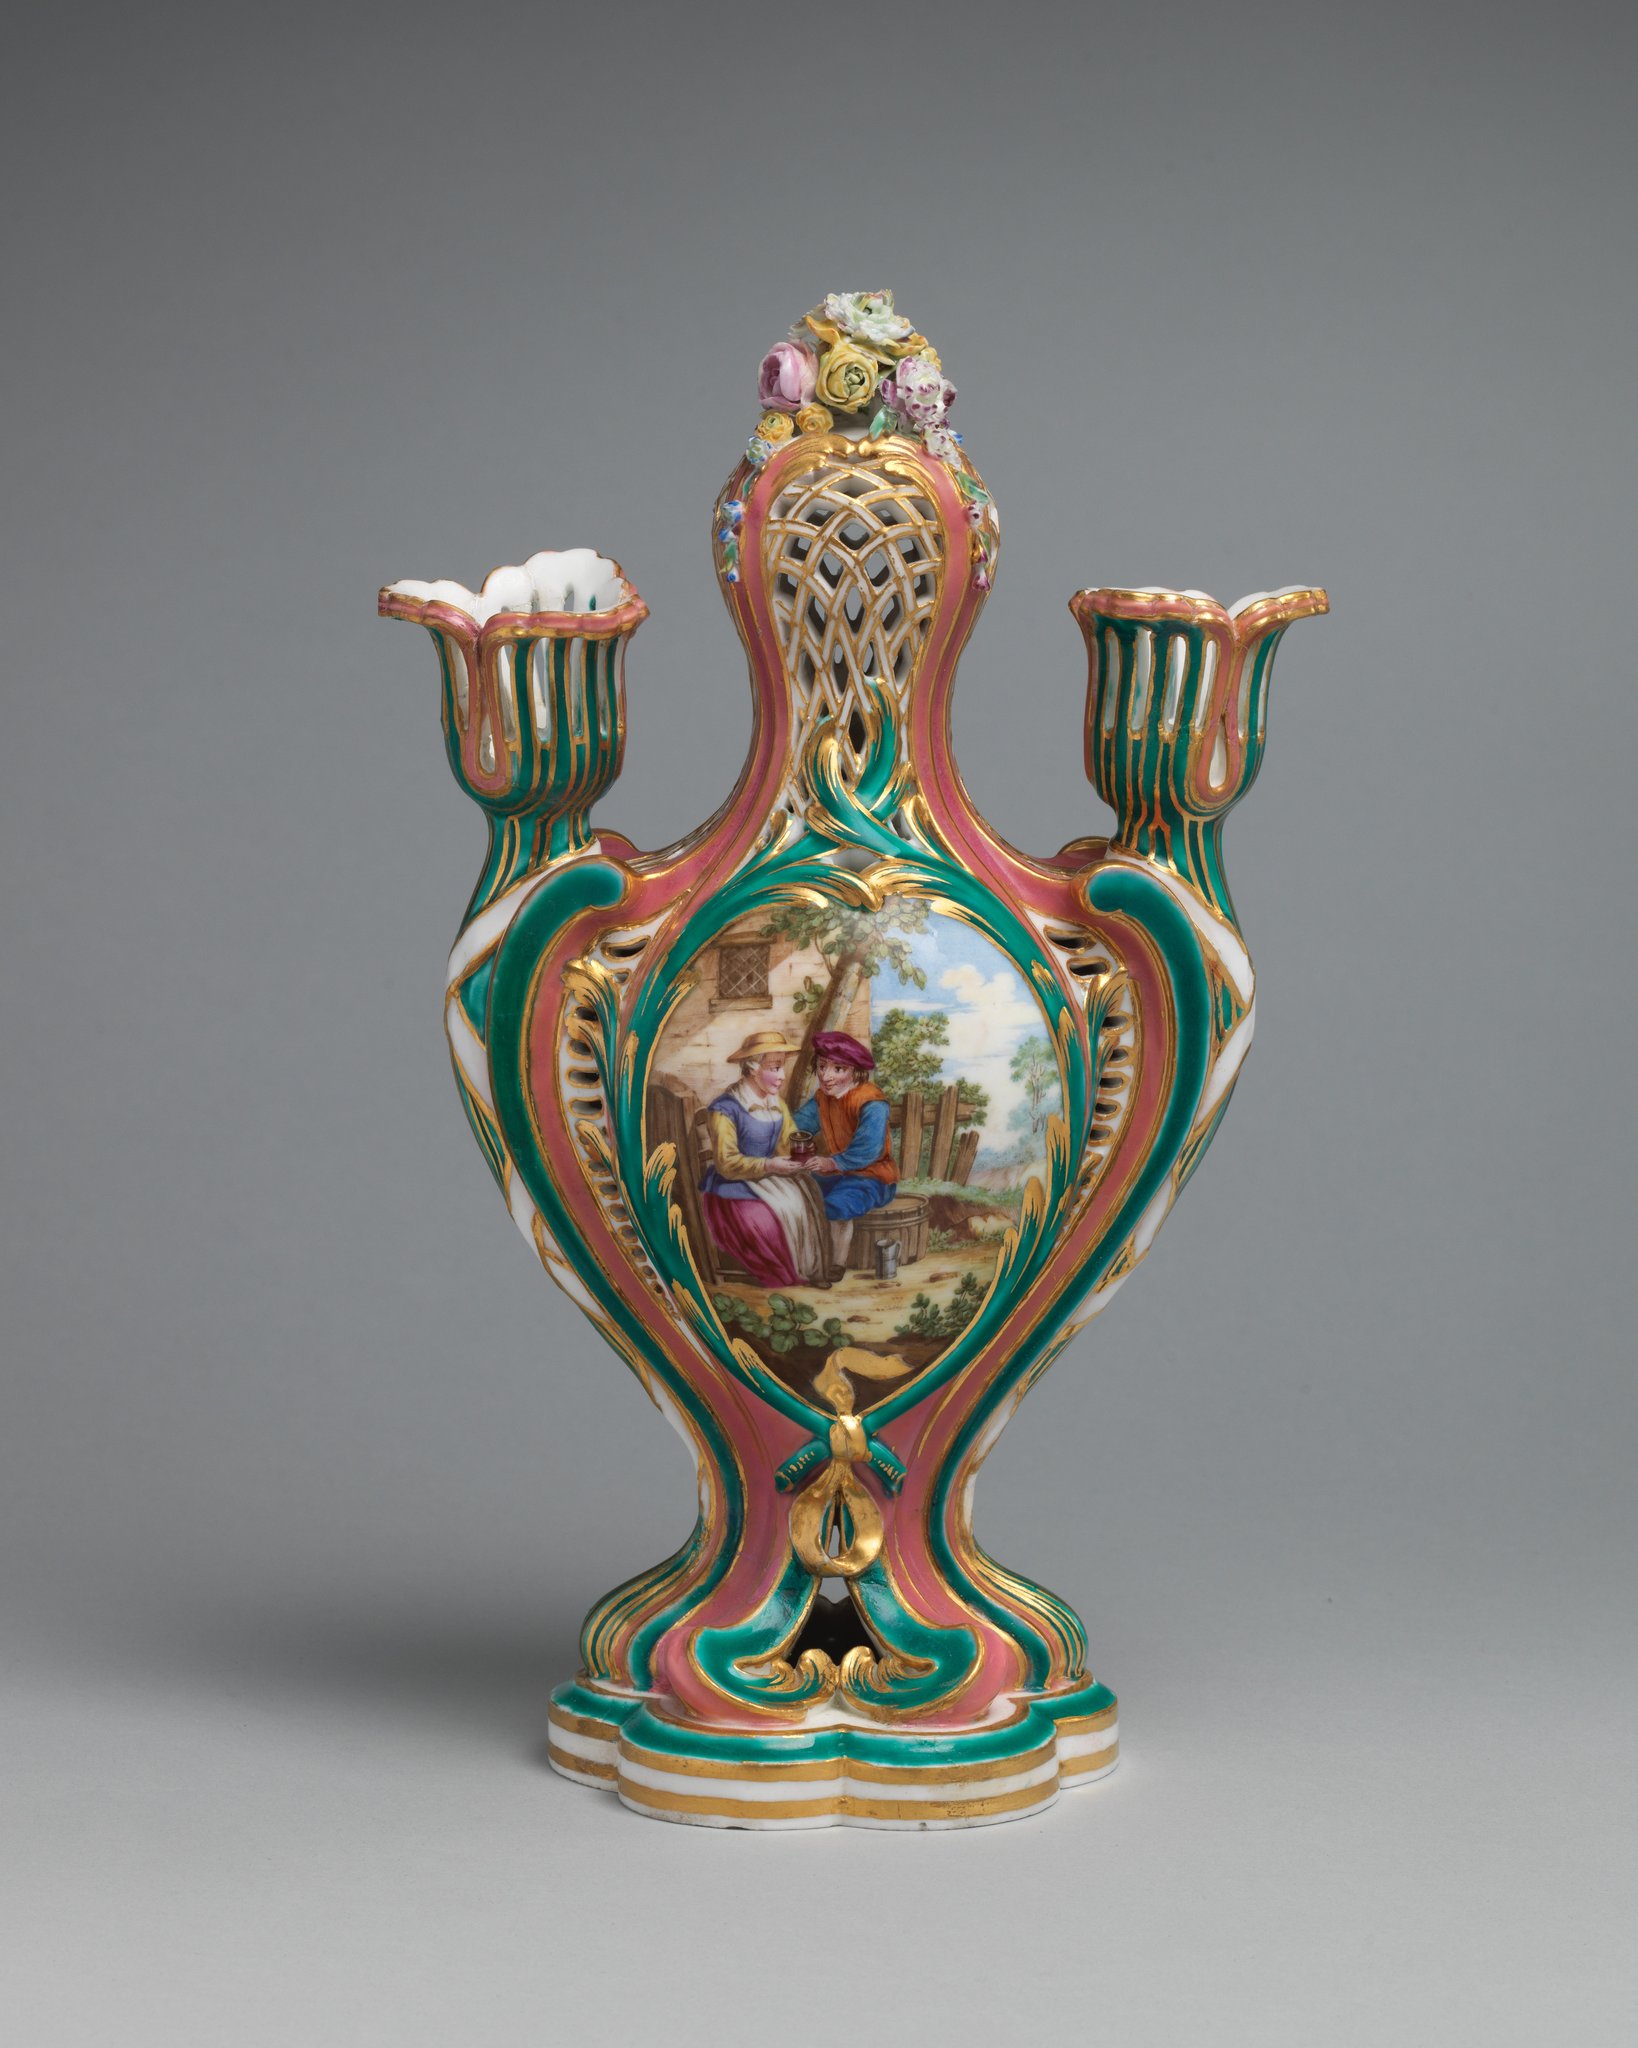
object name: potpourri vase with candleholders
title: Potpourri vase with candleholders (pot-pourri à bobêche) (one of a pair)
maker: sèvres manufactory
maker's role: manufactory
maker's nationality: french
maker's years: 1740-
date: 1760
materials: soft paste porcelain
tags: men,women,flowers